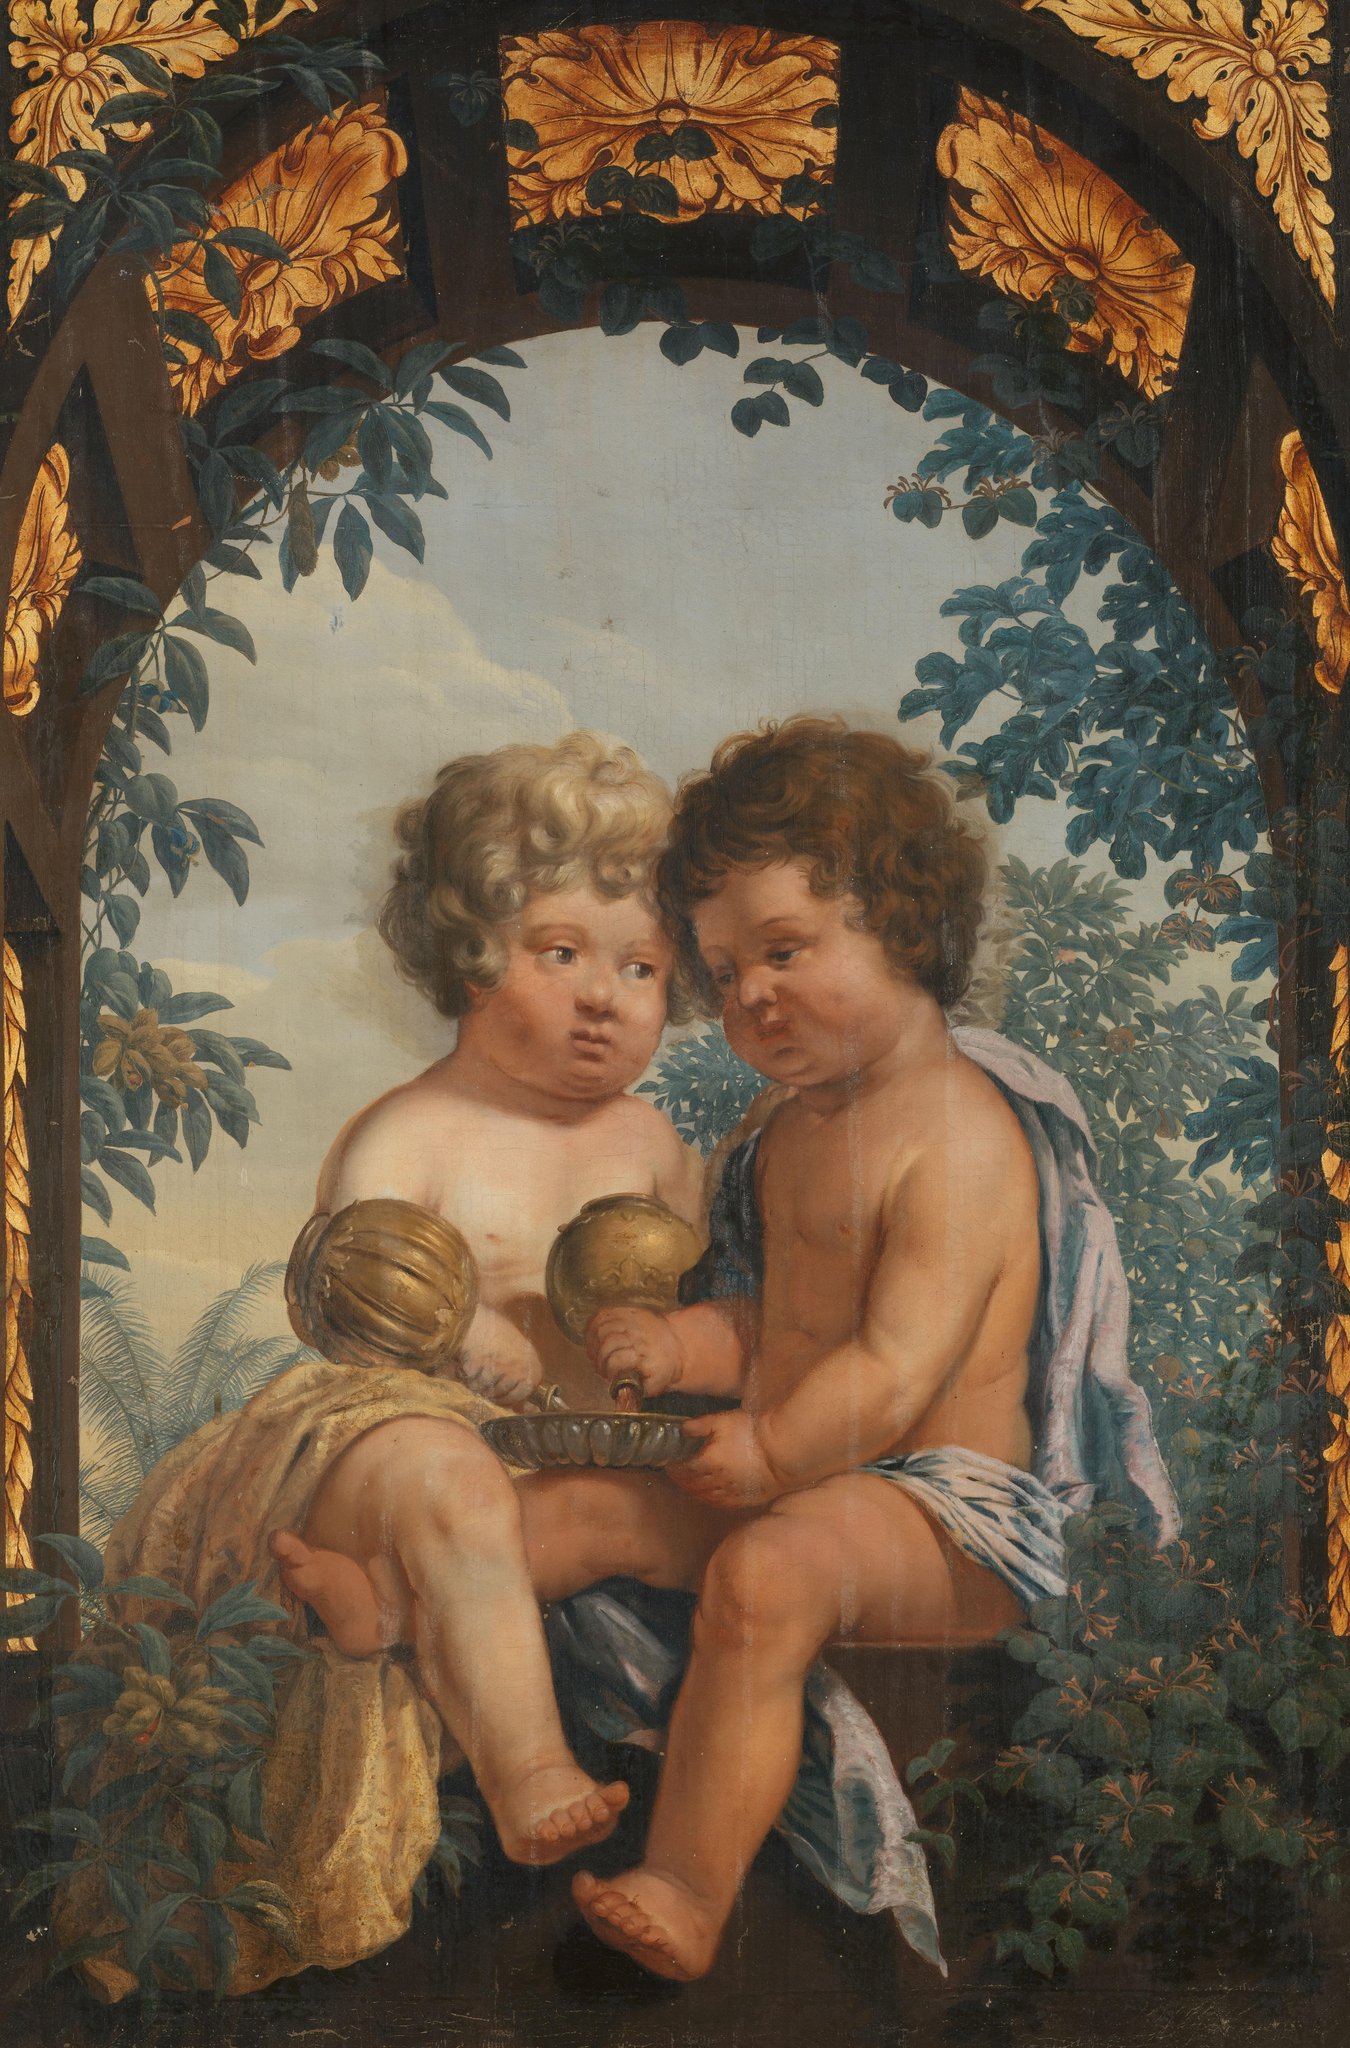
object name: painting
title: Christian Allegory with two Children both Pouring from a Carafe into a Bowl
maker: Anonymous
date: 1650-1699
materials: canvas, oil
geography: northern netherlands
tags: (liturgical) equipment of church, temperance, 'temperantia'; 'temperanza' (ripa) ~ one of the four cardinal virtues, child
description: Christelijke allegorie met twee kinderen die elk een karaf in een schaal uitgieten. Onderdeel van een reeks van vier decoratiestukken met op elk een christelijke allegorie met twee kindertjes (SK-A-1211/1214).